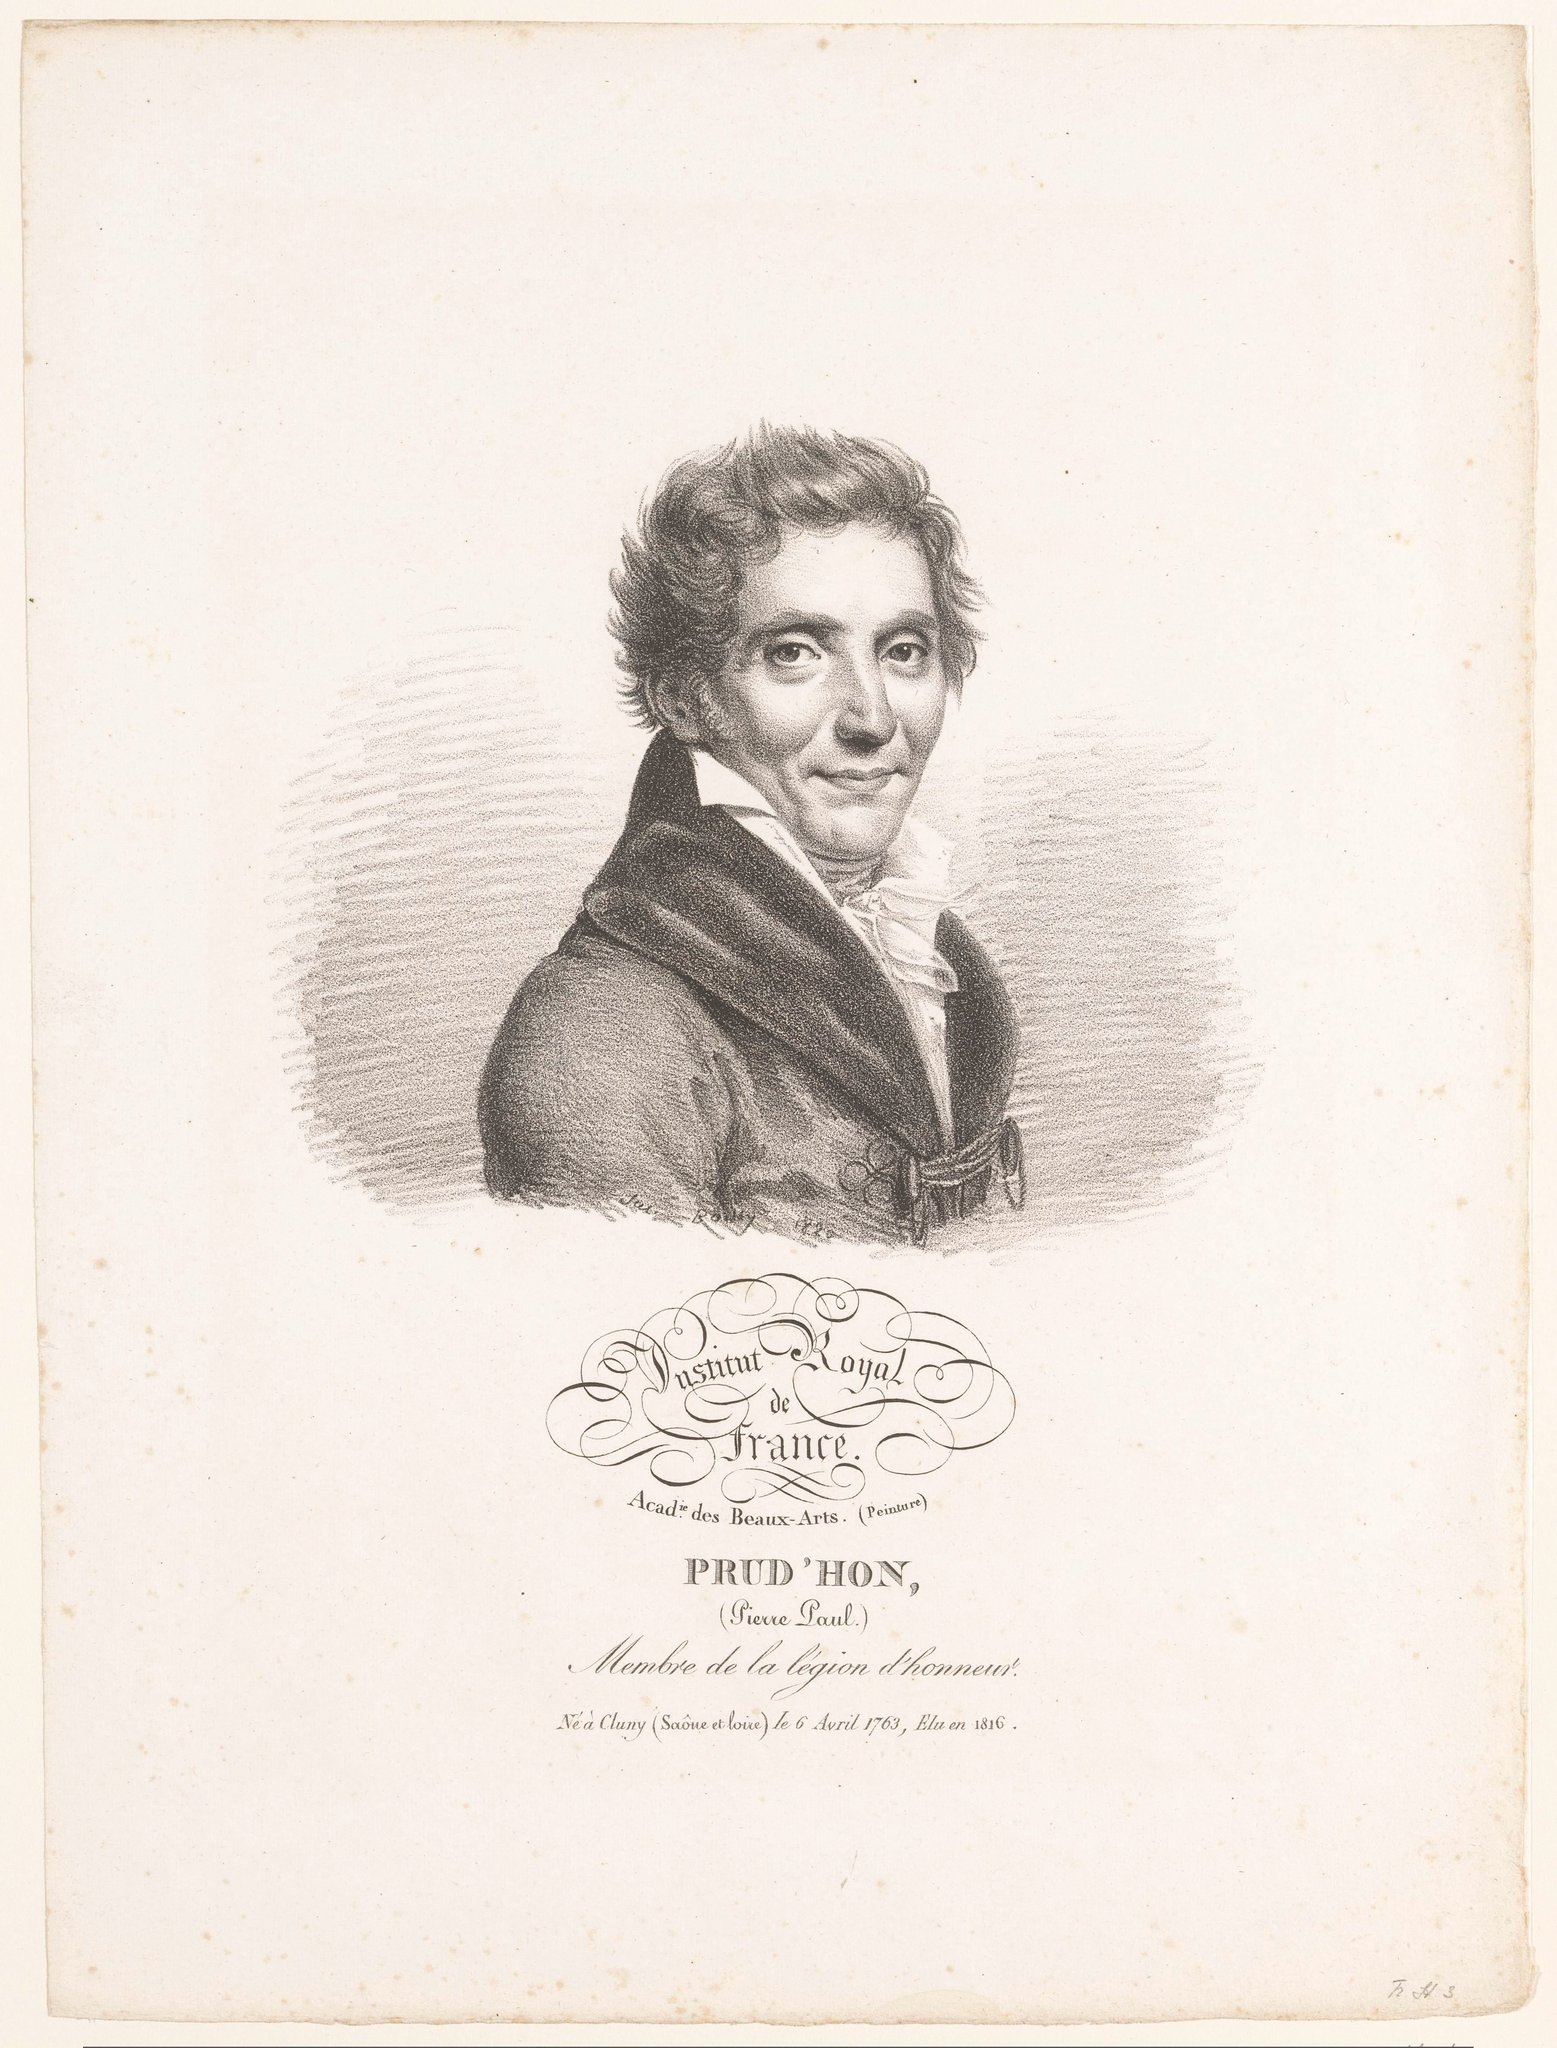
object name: print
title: Iconographie de l'Institut Royal de France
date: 1820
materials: paper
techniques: lithograph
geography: paris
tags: paris, painter, print maker, draughtsman, publisher, pierre prud'hon, historical persons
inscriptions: collector's mark: Lugt 2228a